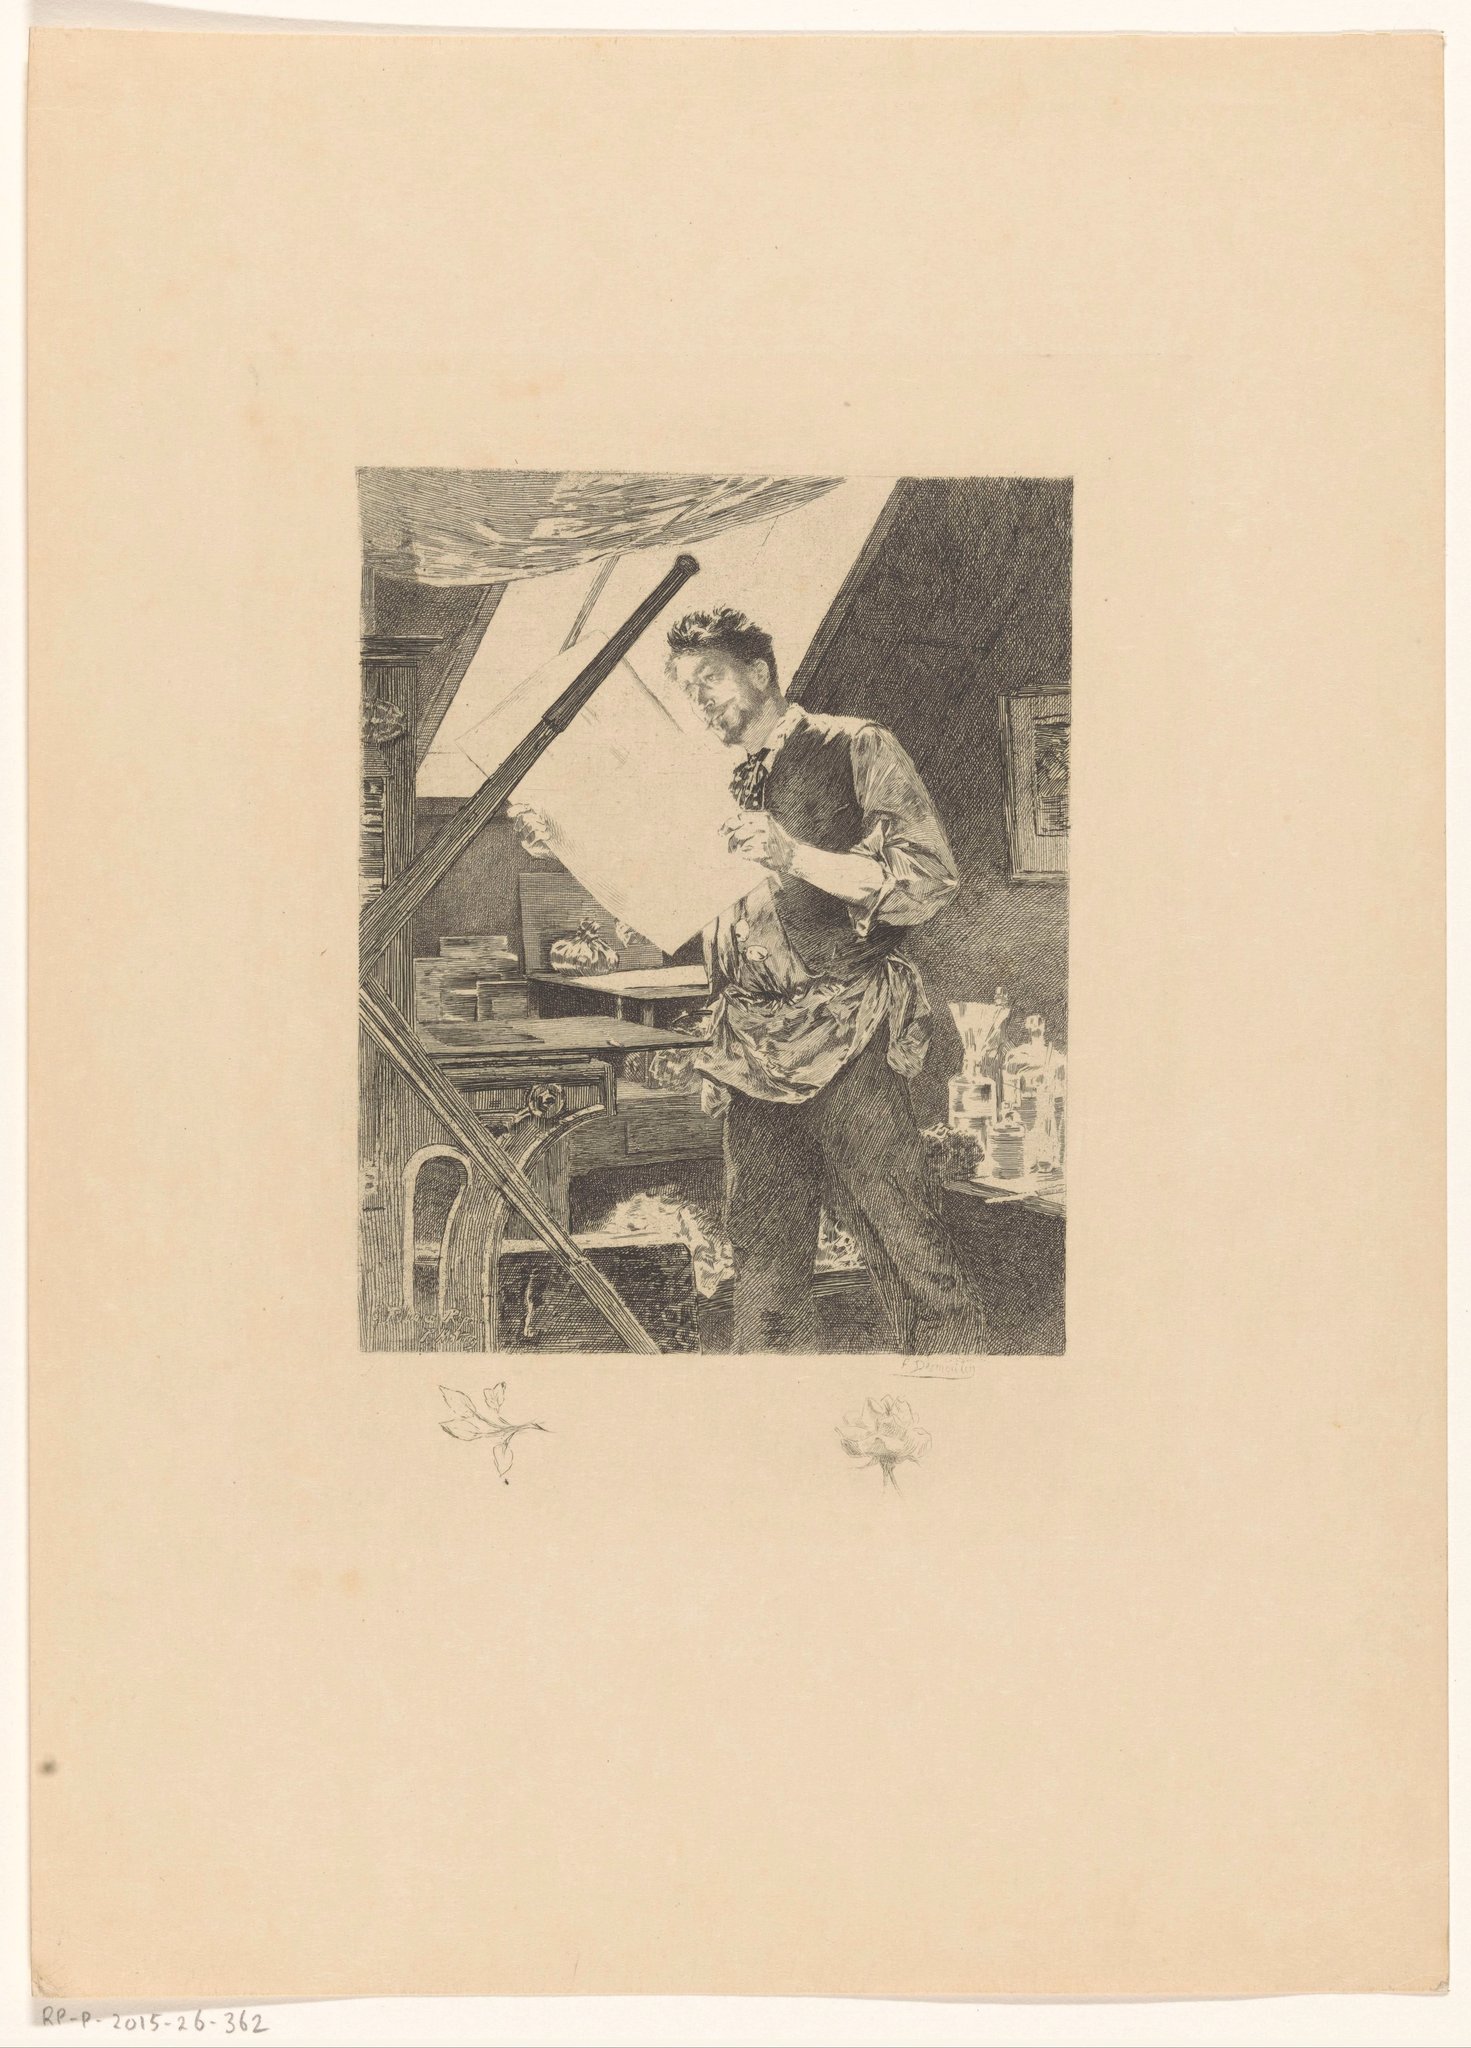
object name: print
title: Portret van Félicien Rops in zijn atelier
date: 1875-1900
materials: paper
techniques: drypoint, etching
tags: draughtsman, félicien rops, print, e.g.: engraving, etching, lithograph, printing press, tools, implements of graphic artist, graphic artist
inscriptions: collector's mark: Lugt 2228, collector's mark: Lugt 4779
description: De prent kan worden vergeleken met het schilderij van Paul Mathey met dezelfde voorstelling (Château Versailles MV 6146), waarop het atelier van de kunstenaar te zien is.